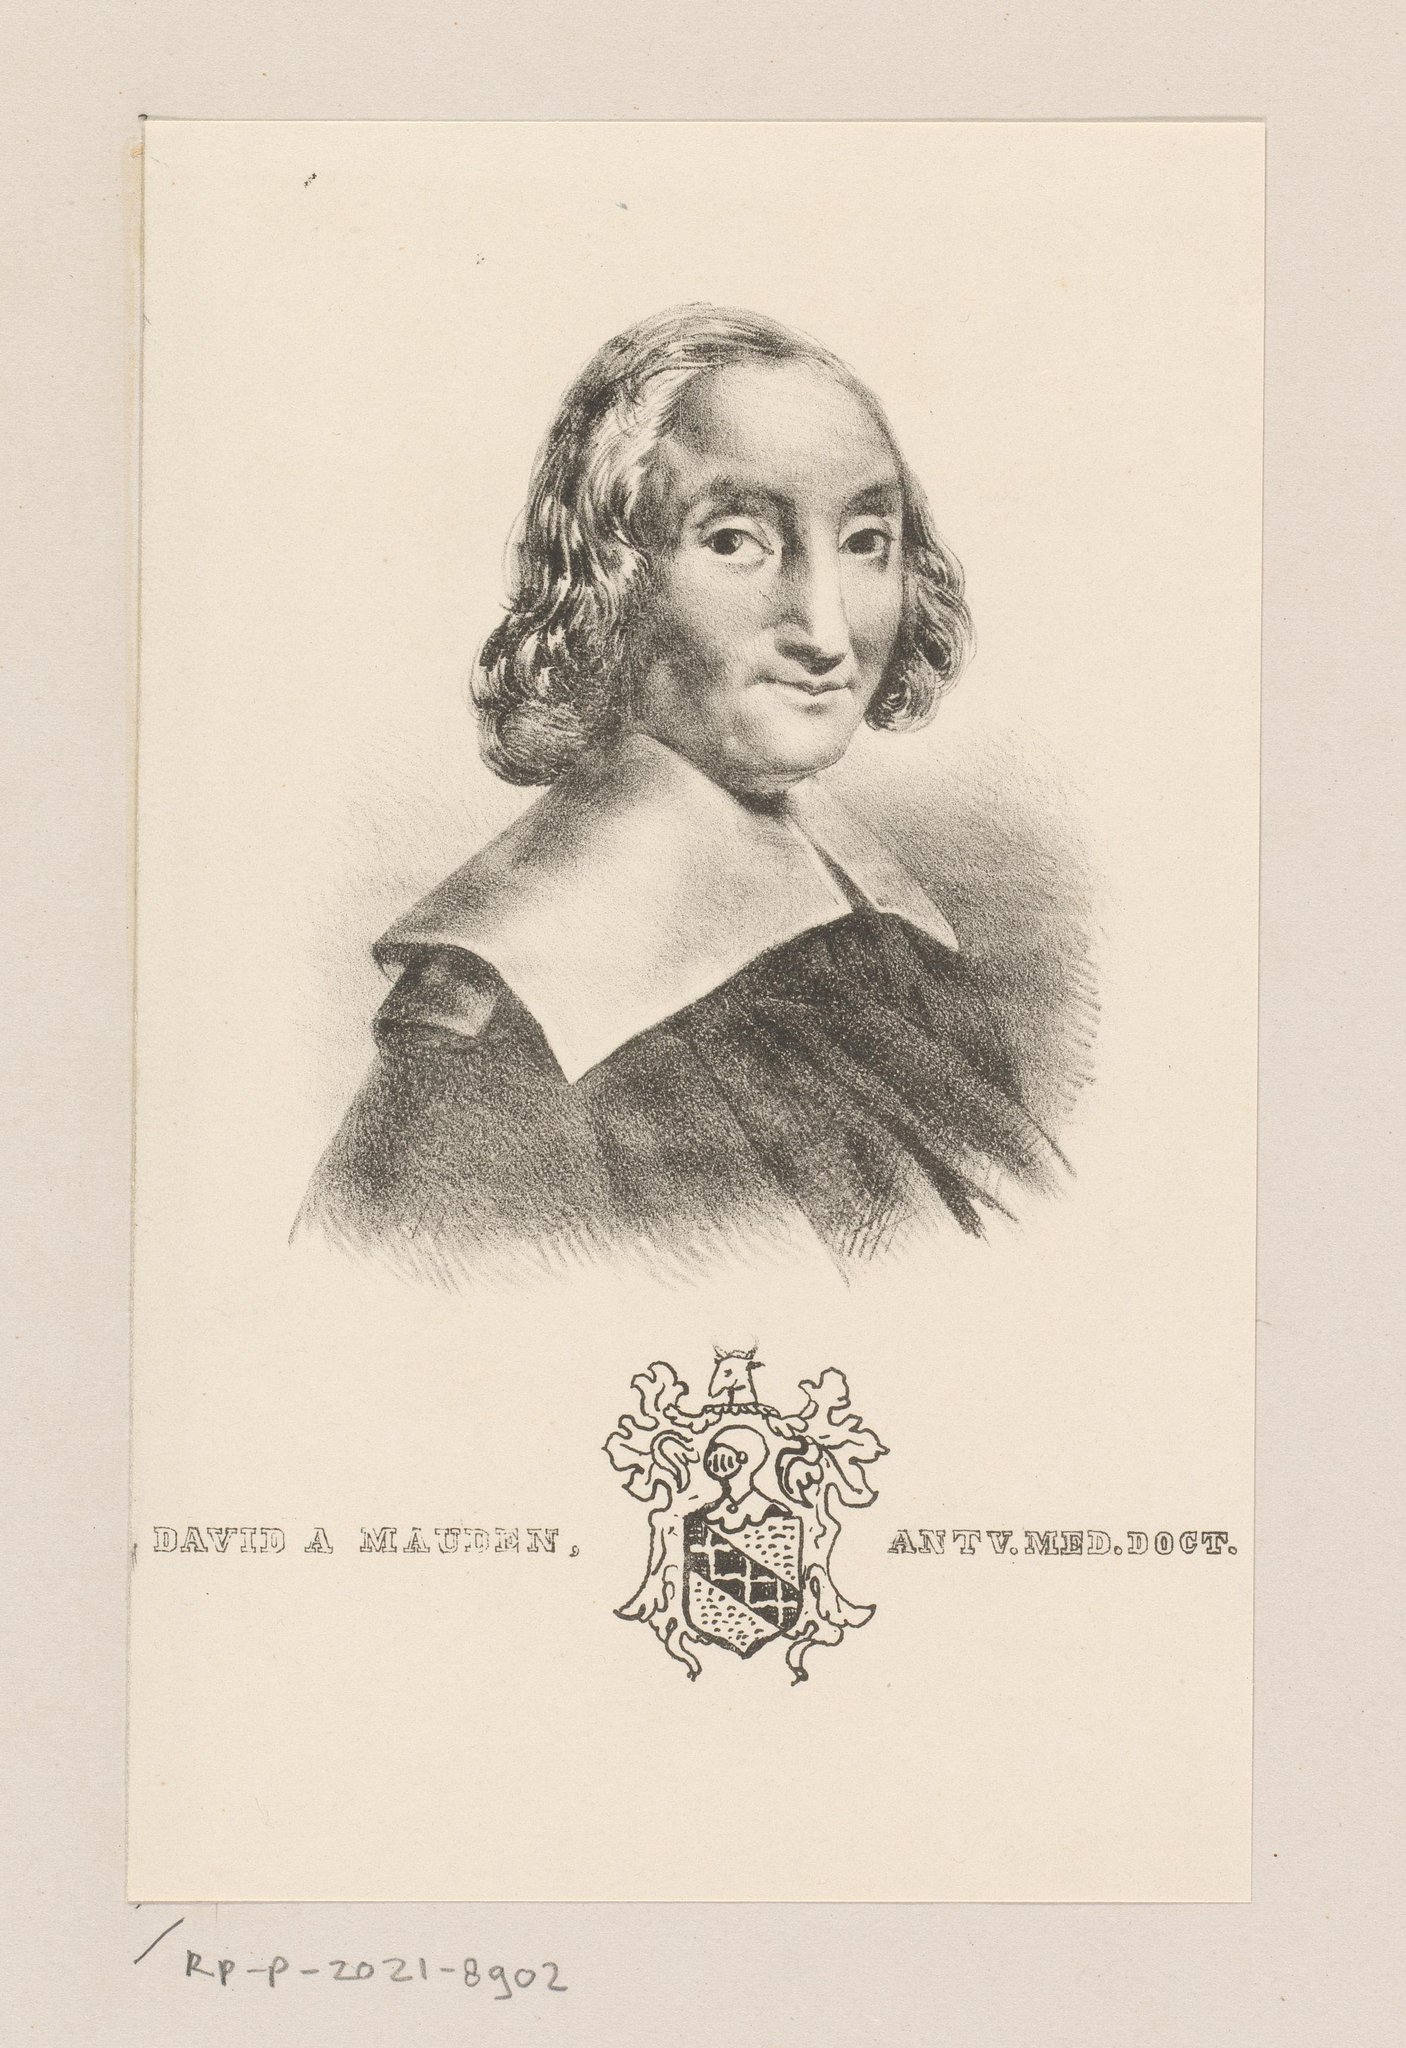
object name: print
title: Portret van David van Mauden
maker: Anonymous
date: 1800-1899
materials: paper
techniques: lithograph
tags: historical persons, physician, doctor (+ portrait of scholar, scientist), armorial bearing, heraldry